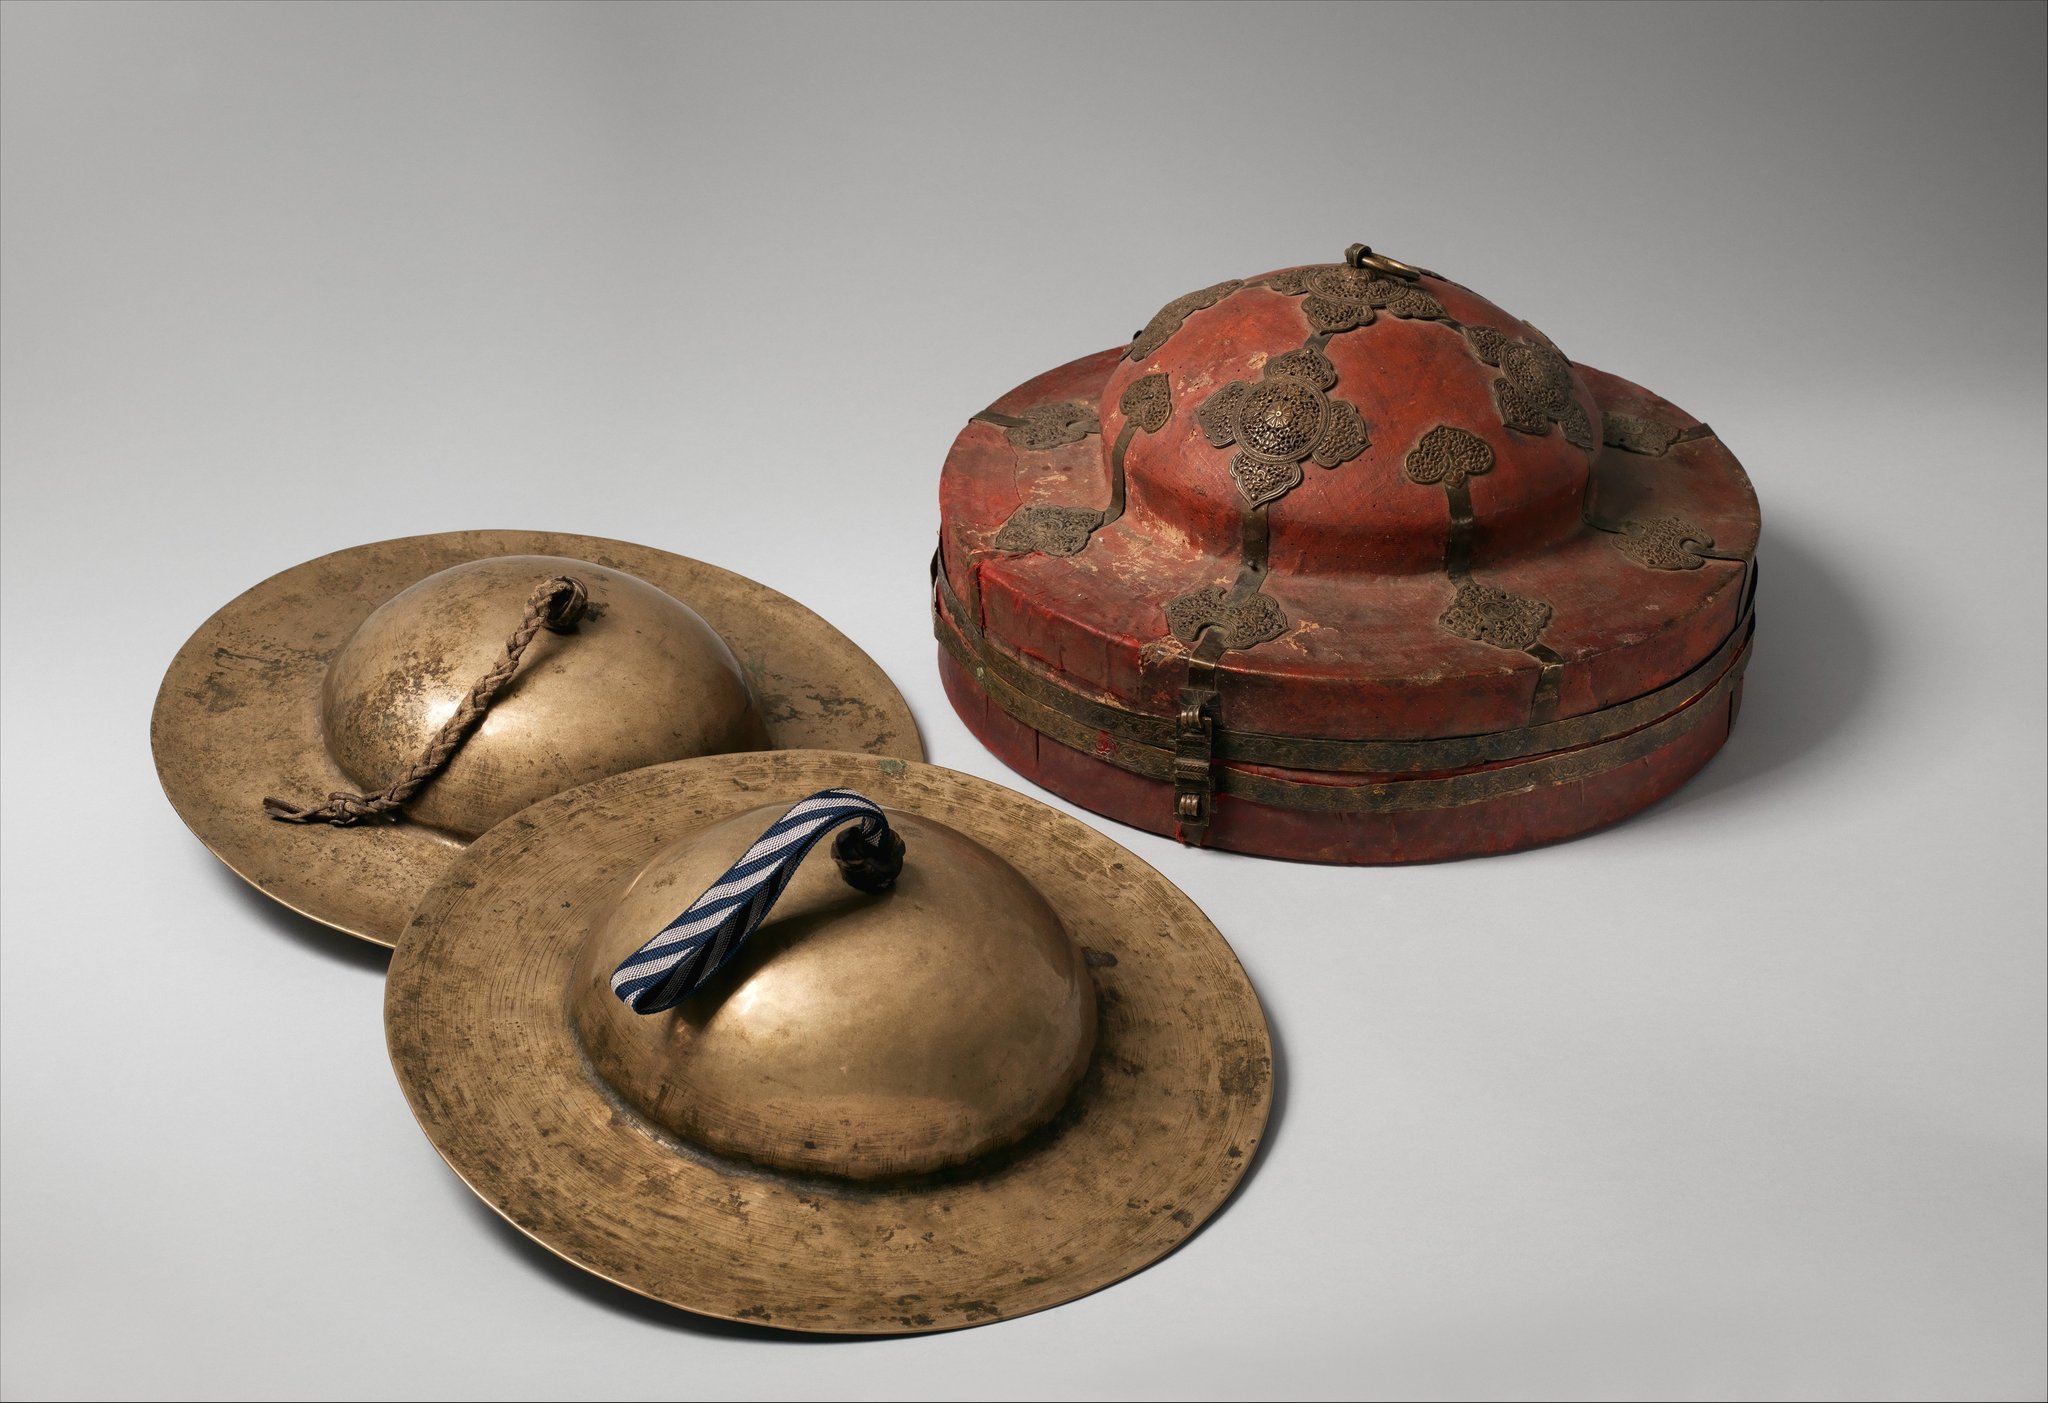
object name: cymbal case with set of cymbal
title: Cymbal Case with Set of Cymbals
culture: chinese or tibetan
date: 1667-1700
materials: textile, metal, wood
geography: tibet